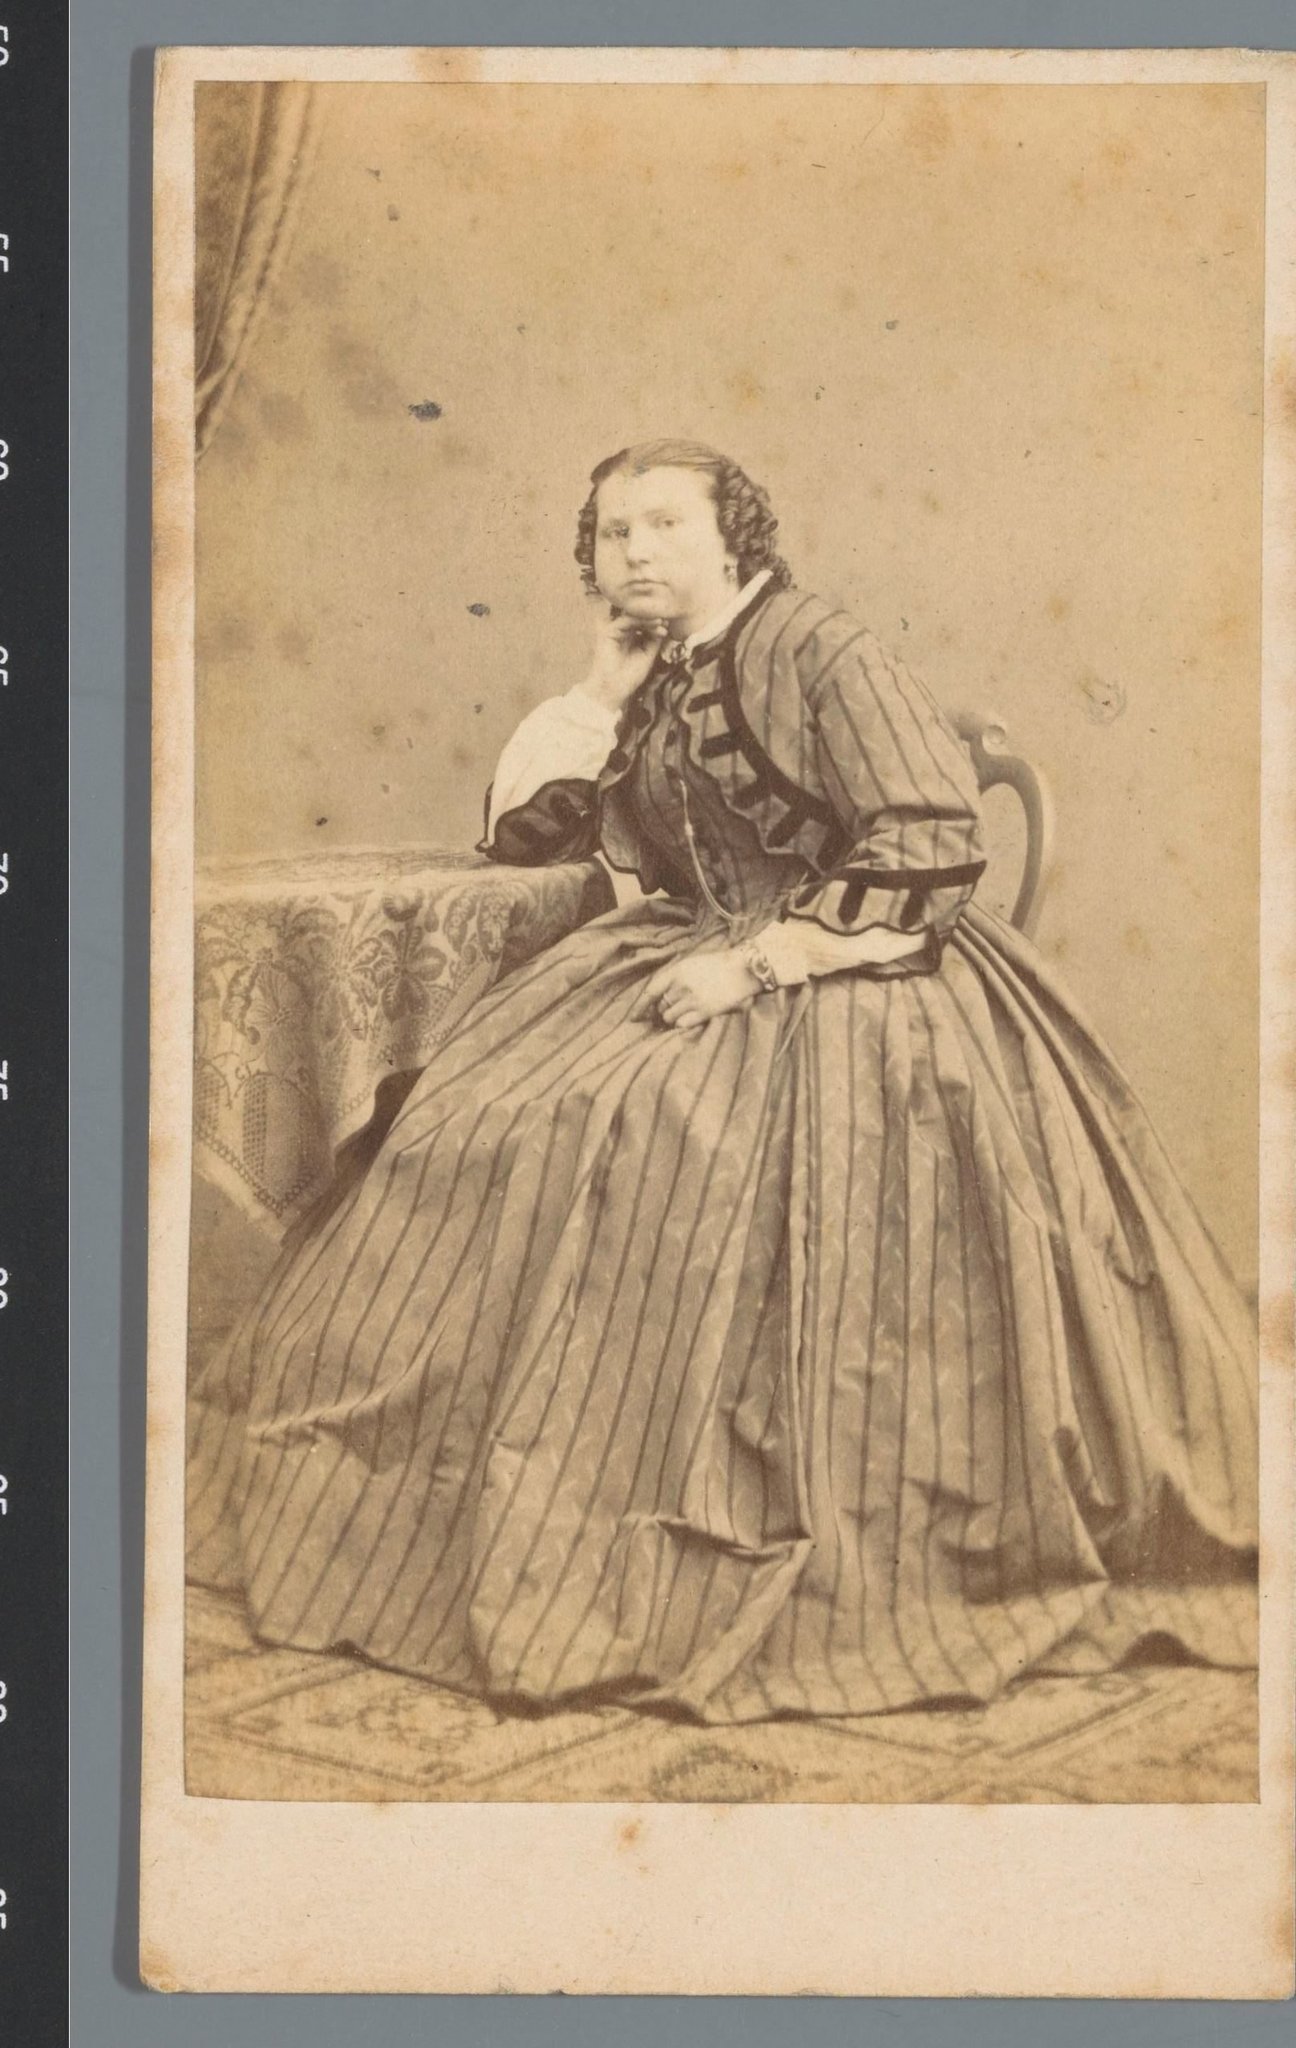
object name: carte de visite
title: Portret van een onbekende vrouw, zittend aan tafel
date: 1865-1871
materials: cardboard, paper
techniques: albumen print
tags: sitting figure, historical persons - bb - woman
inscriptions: inscription: ‘van der Kruk & Behr/ Firma:/ J. H. BUCKMANN/ 2 Wagenstraat No. 129/ 'S HAGE.’